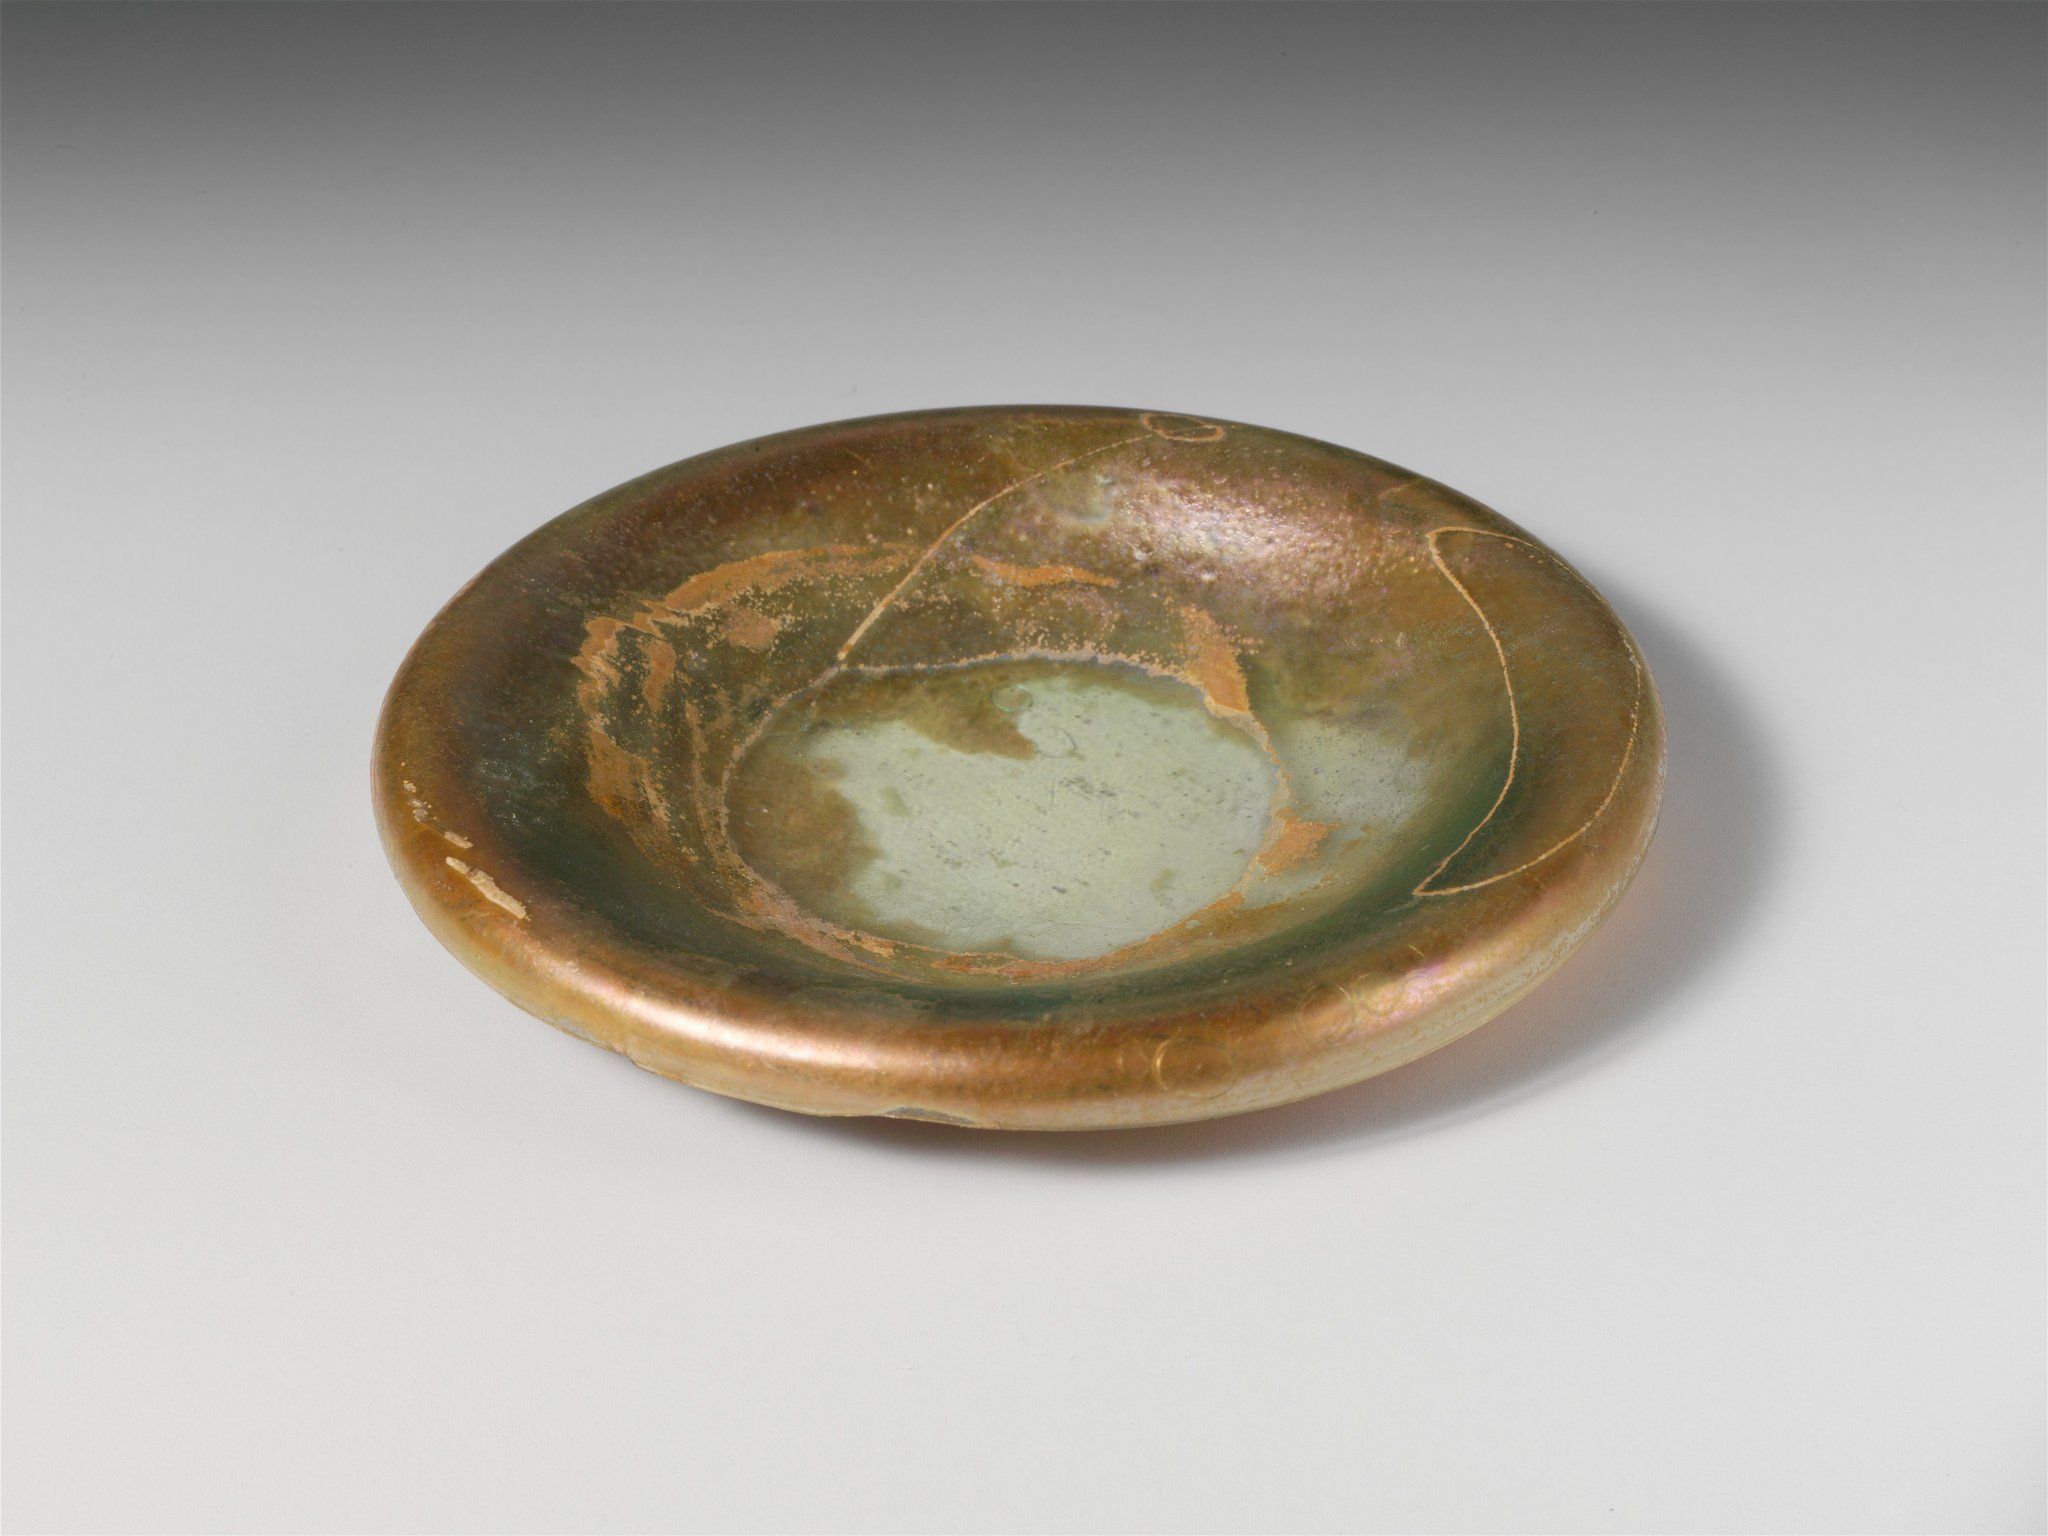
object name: lid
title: Glass lid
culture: roman, cypriot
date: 101-300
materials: glass